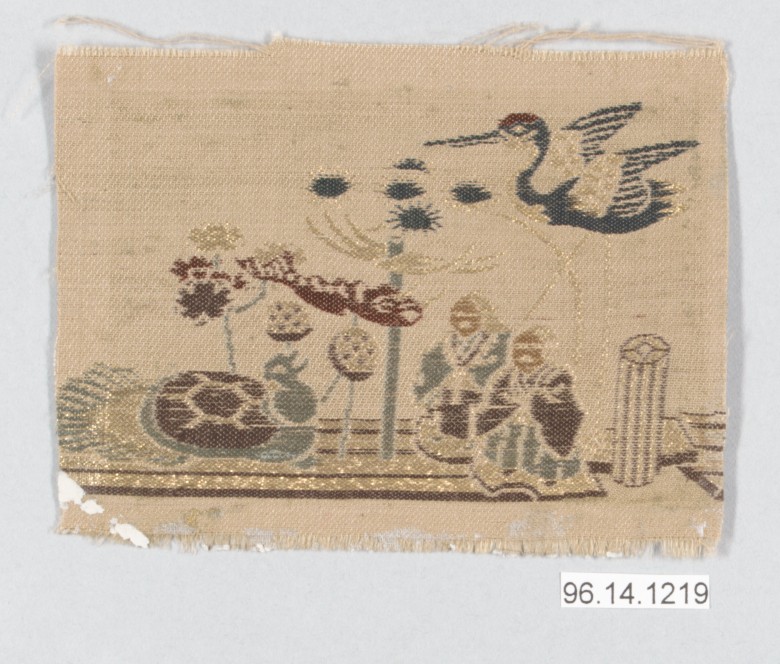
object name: piece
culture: japanese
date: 1801-1900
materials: metal thread, silk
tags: human figures